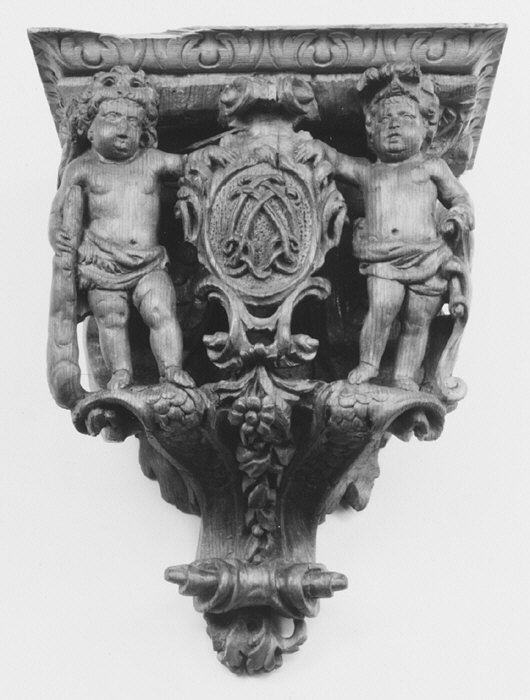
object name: wall bracket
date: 1667-1700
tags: putti